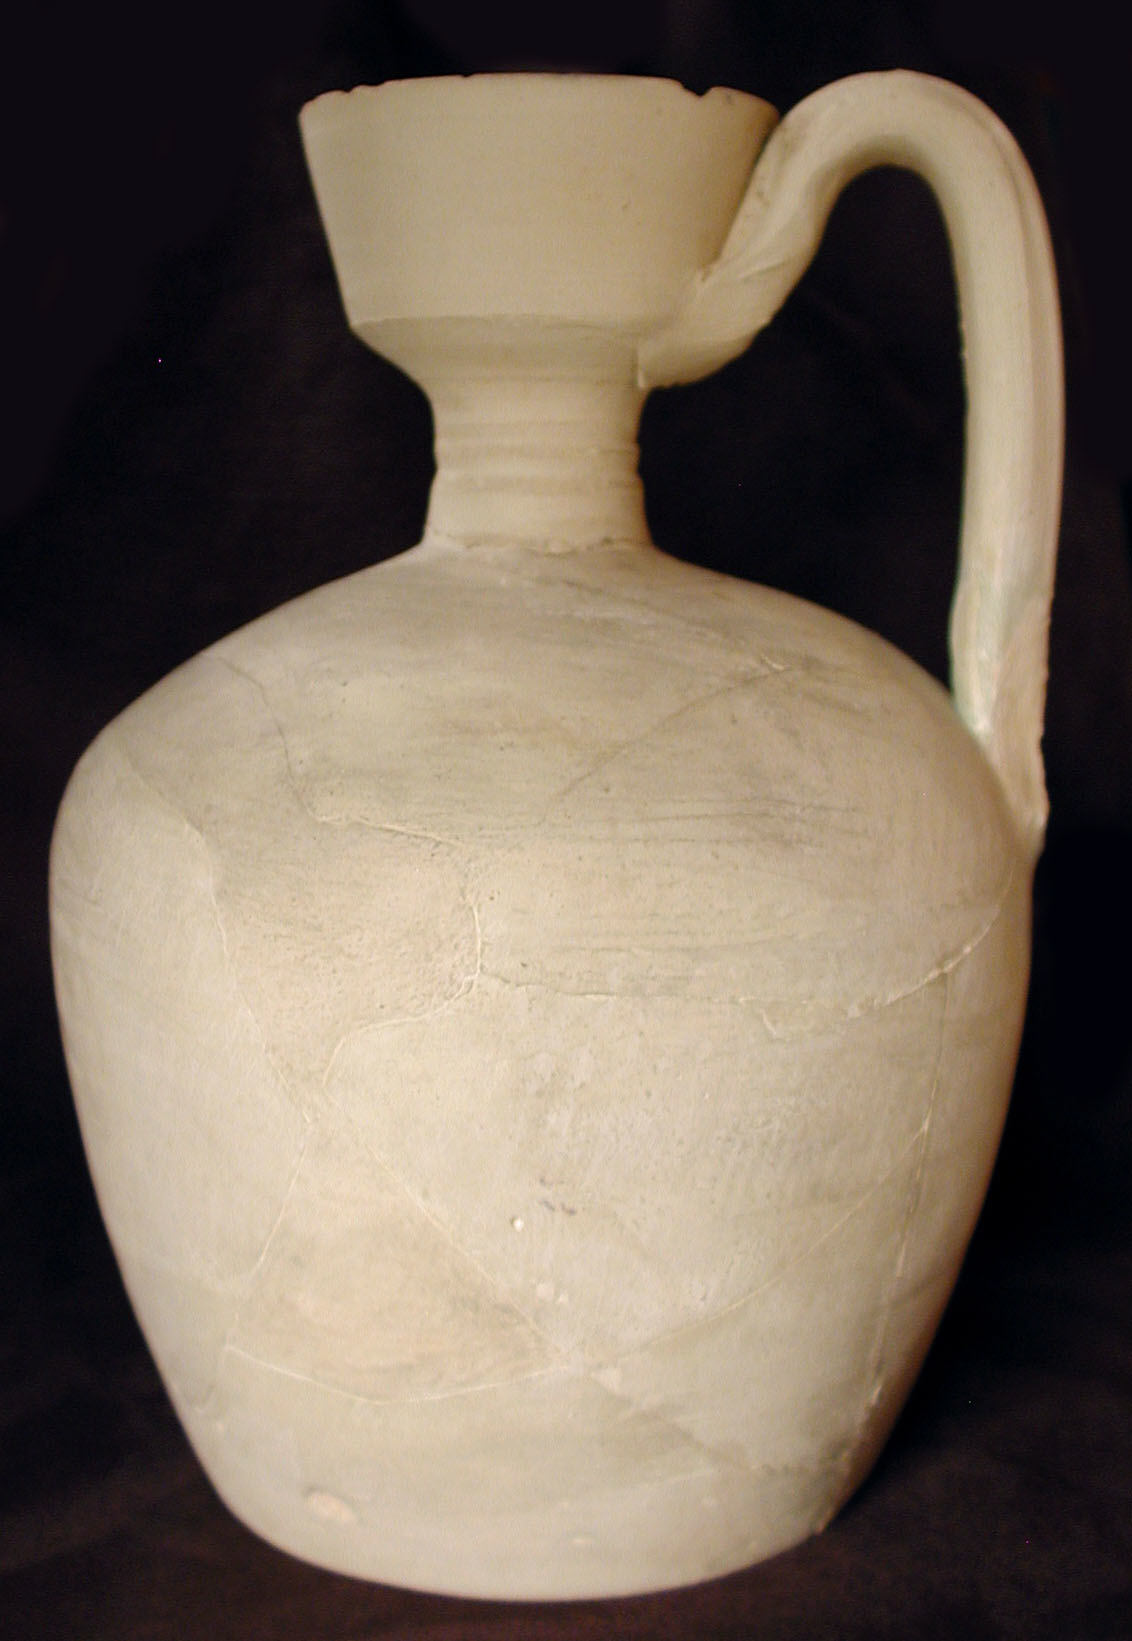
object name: ewer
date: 801-1000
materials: earthenware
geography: iran